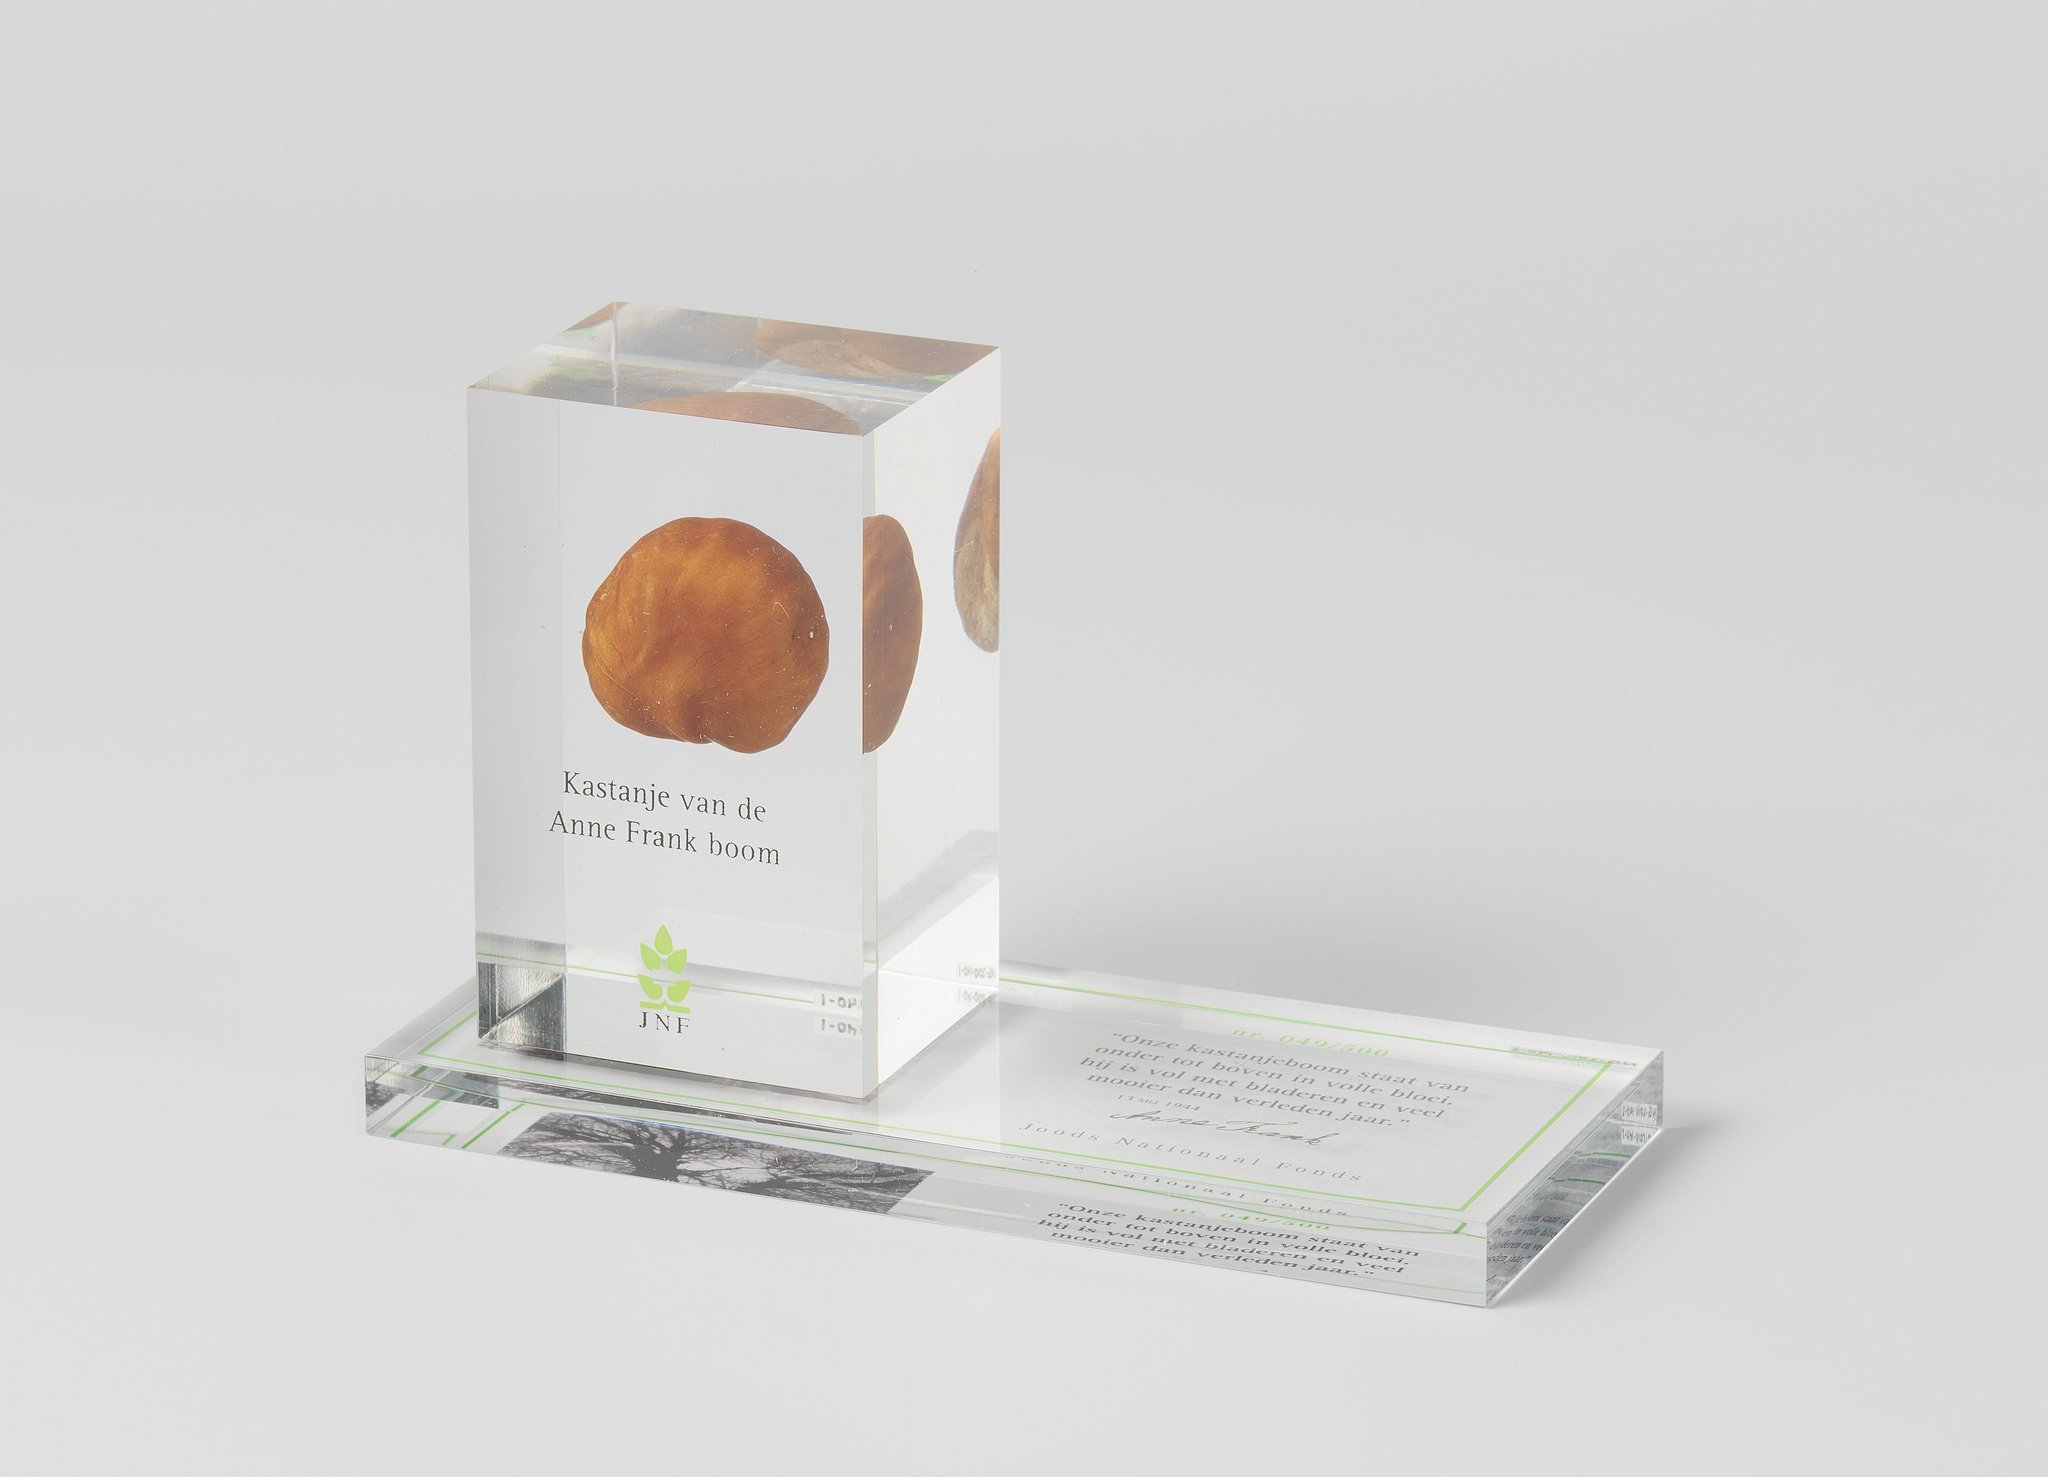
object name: box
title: Oorspronkelijke verpakking kastanje Anne Frank boom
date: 2010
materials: cardboard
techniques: printing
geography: netherlands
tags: anne frank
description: Kartonnen doosje dat dient als verpakking van de verschillende onderdelen van het herinneringsobject van de Anne Frankboom. Aan de buitenkant in zwart, grijstinten en groen bedrukt met afbeeldingen en teksten die toelichting op het object geven.